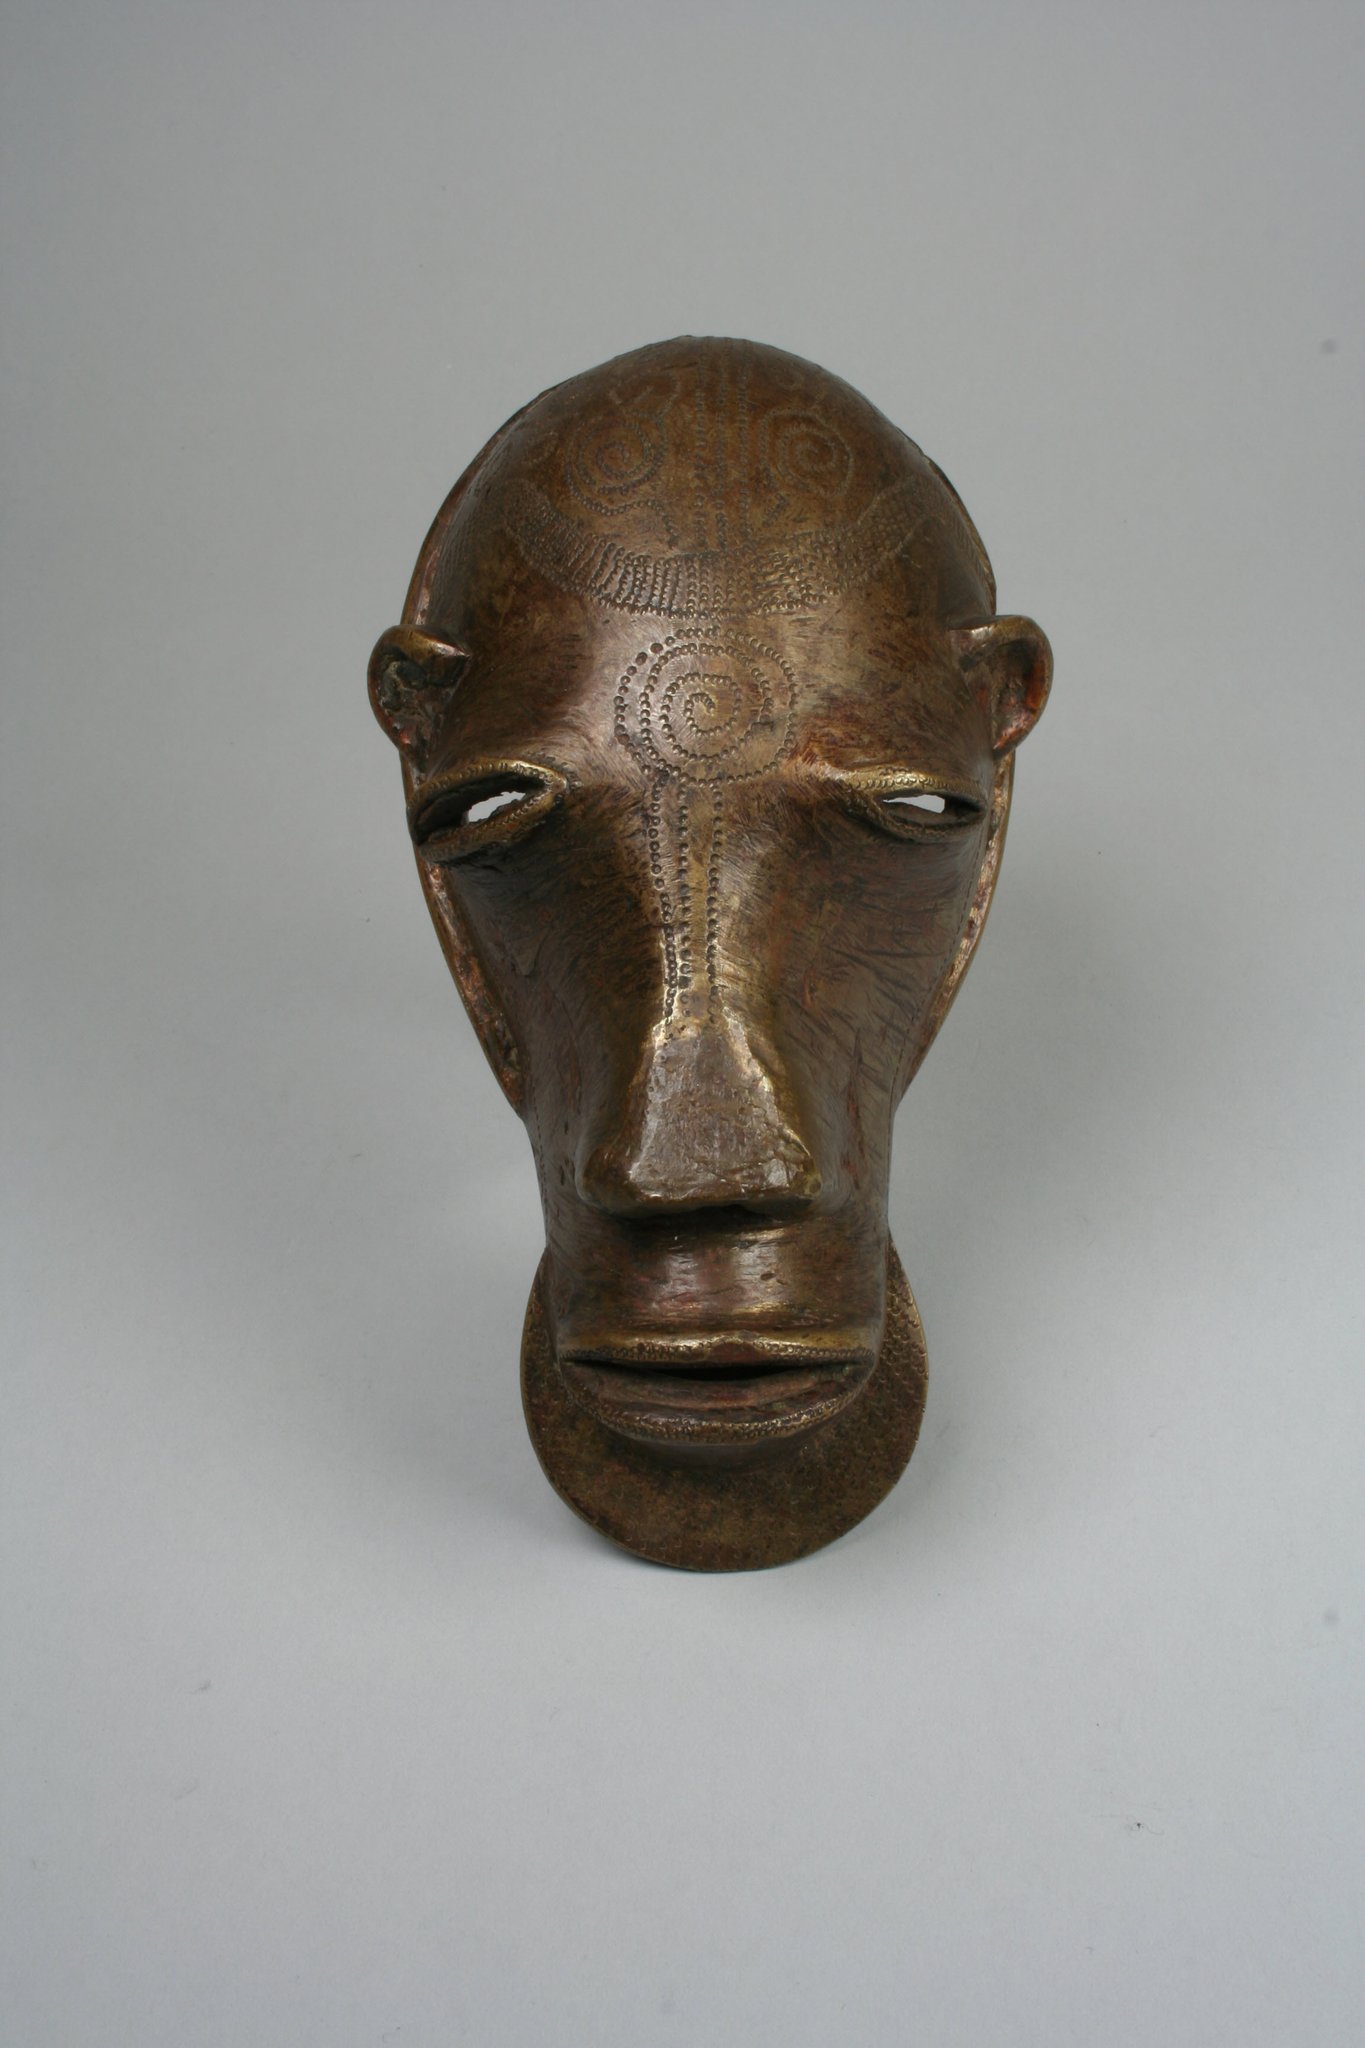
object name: weight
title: Gold Weight: Mask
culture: brong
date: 1601-1800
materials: brass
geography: ghana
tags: masks